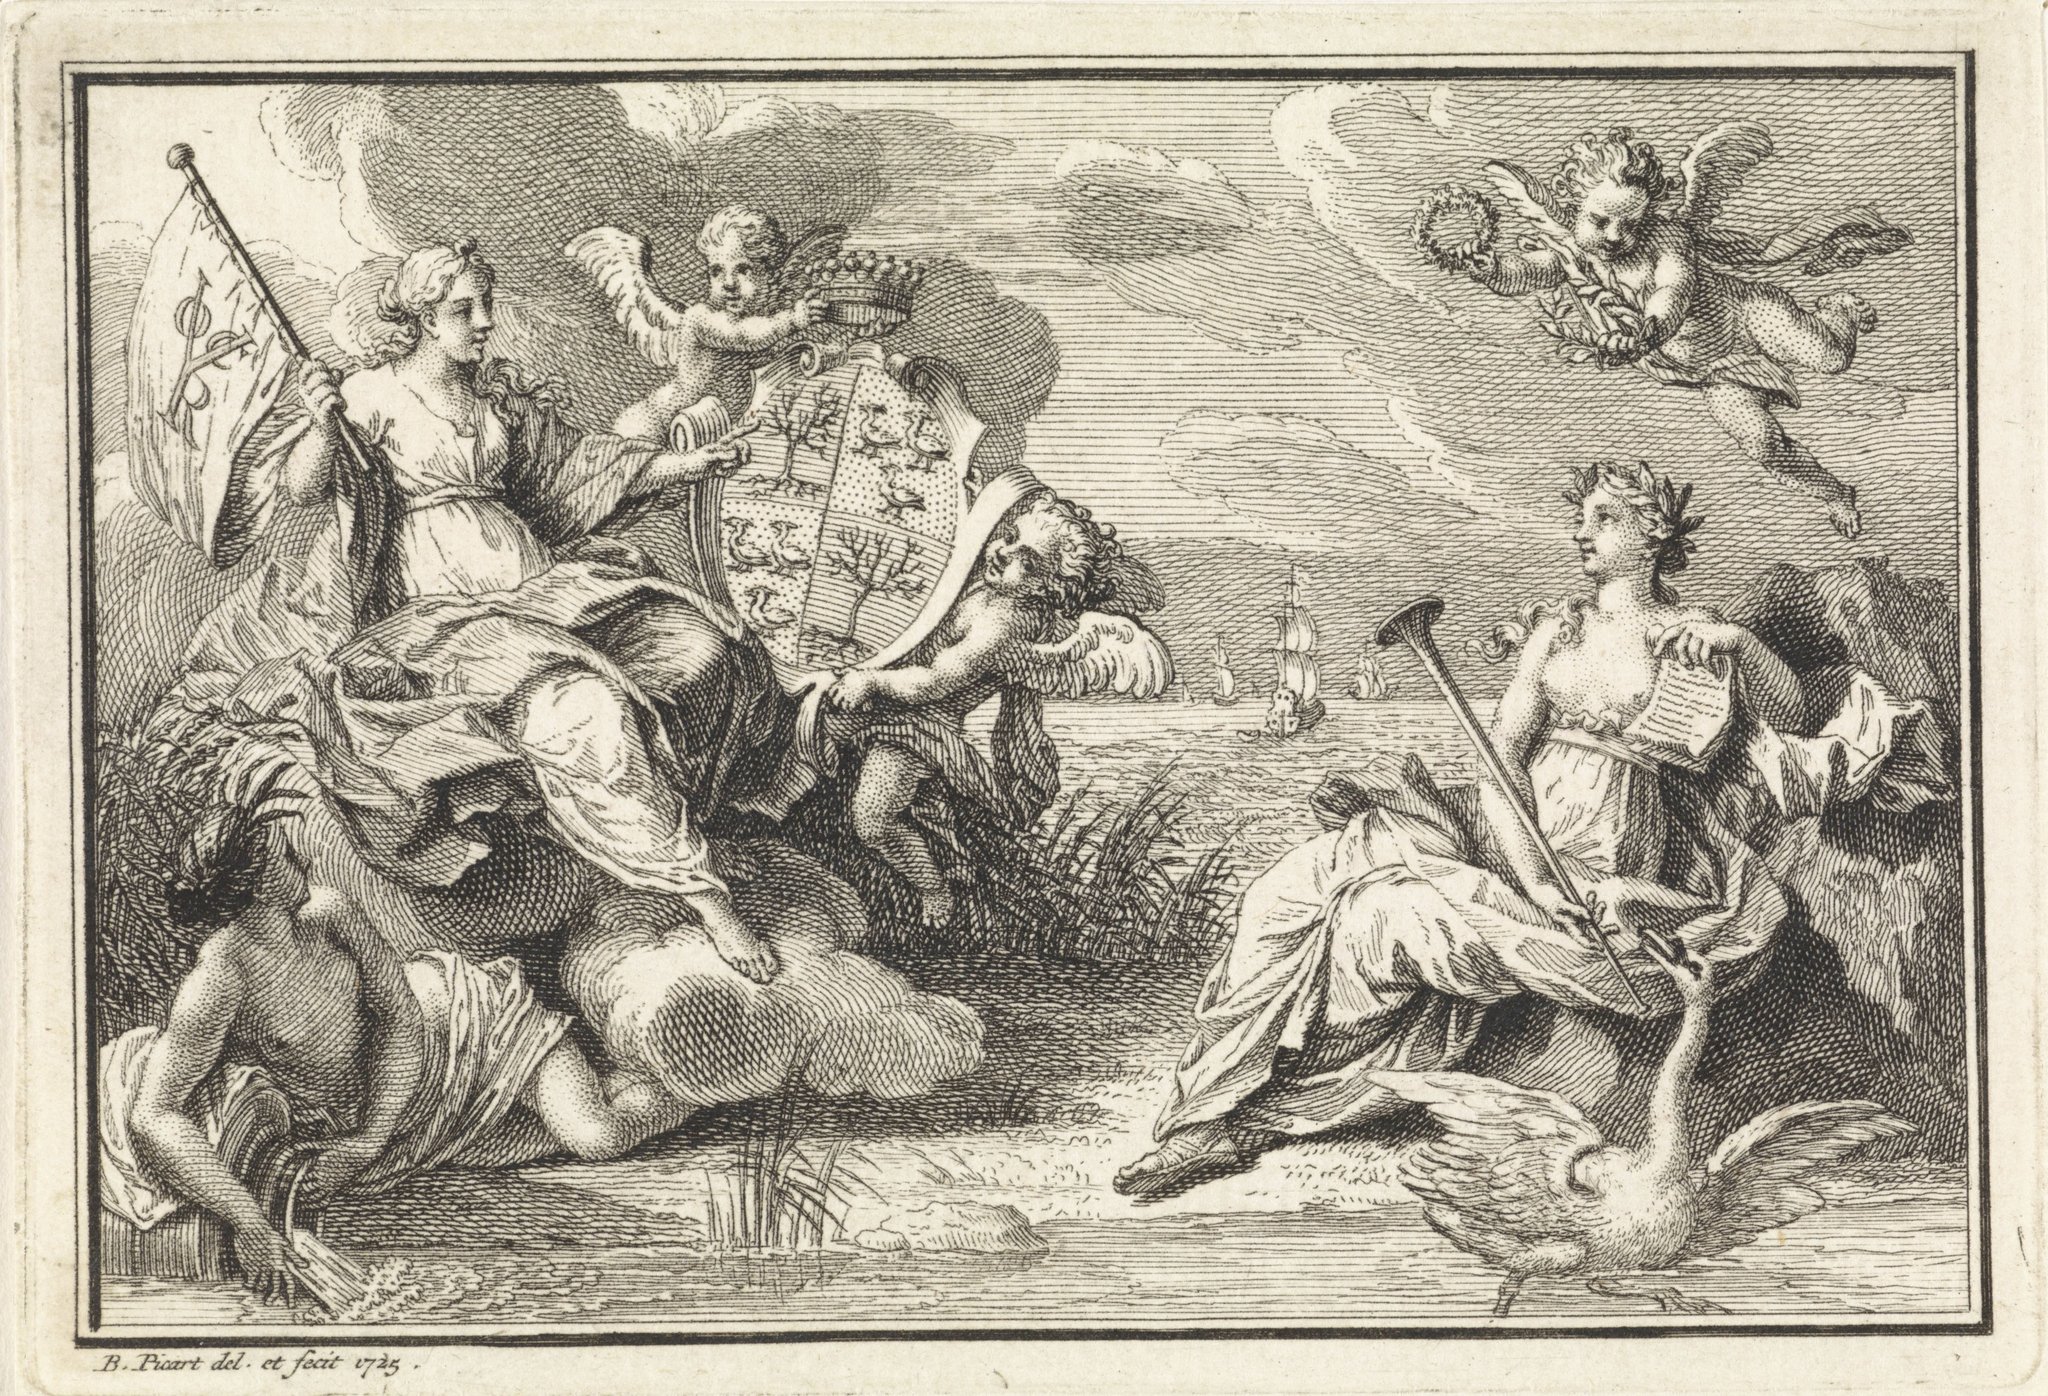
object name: print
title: Stedenmaagd met wapenschild, Faam en stroomgodin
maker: bernard picart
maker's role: draughtsman, print maker, publisher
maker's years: 1673-1733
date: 1725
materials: paper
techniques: engraving, etching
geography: amsterdam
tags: personification of a city, town-patron(ess), fame; 'fama', 'fama buona', 'fama chiara' (ripa)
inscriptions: collector's mark: Lugt 240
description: Een stedenmaagd met het banier van de Rotterdamse kamer van de VOC toont een wapenschild. Putti dragen en kronen het wapenschild. Rechts zit Faam. Op de voorgrond een stroomgodin en op de achtergrond de zee.